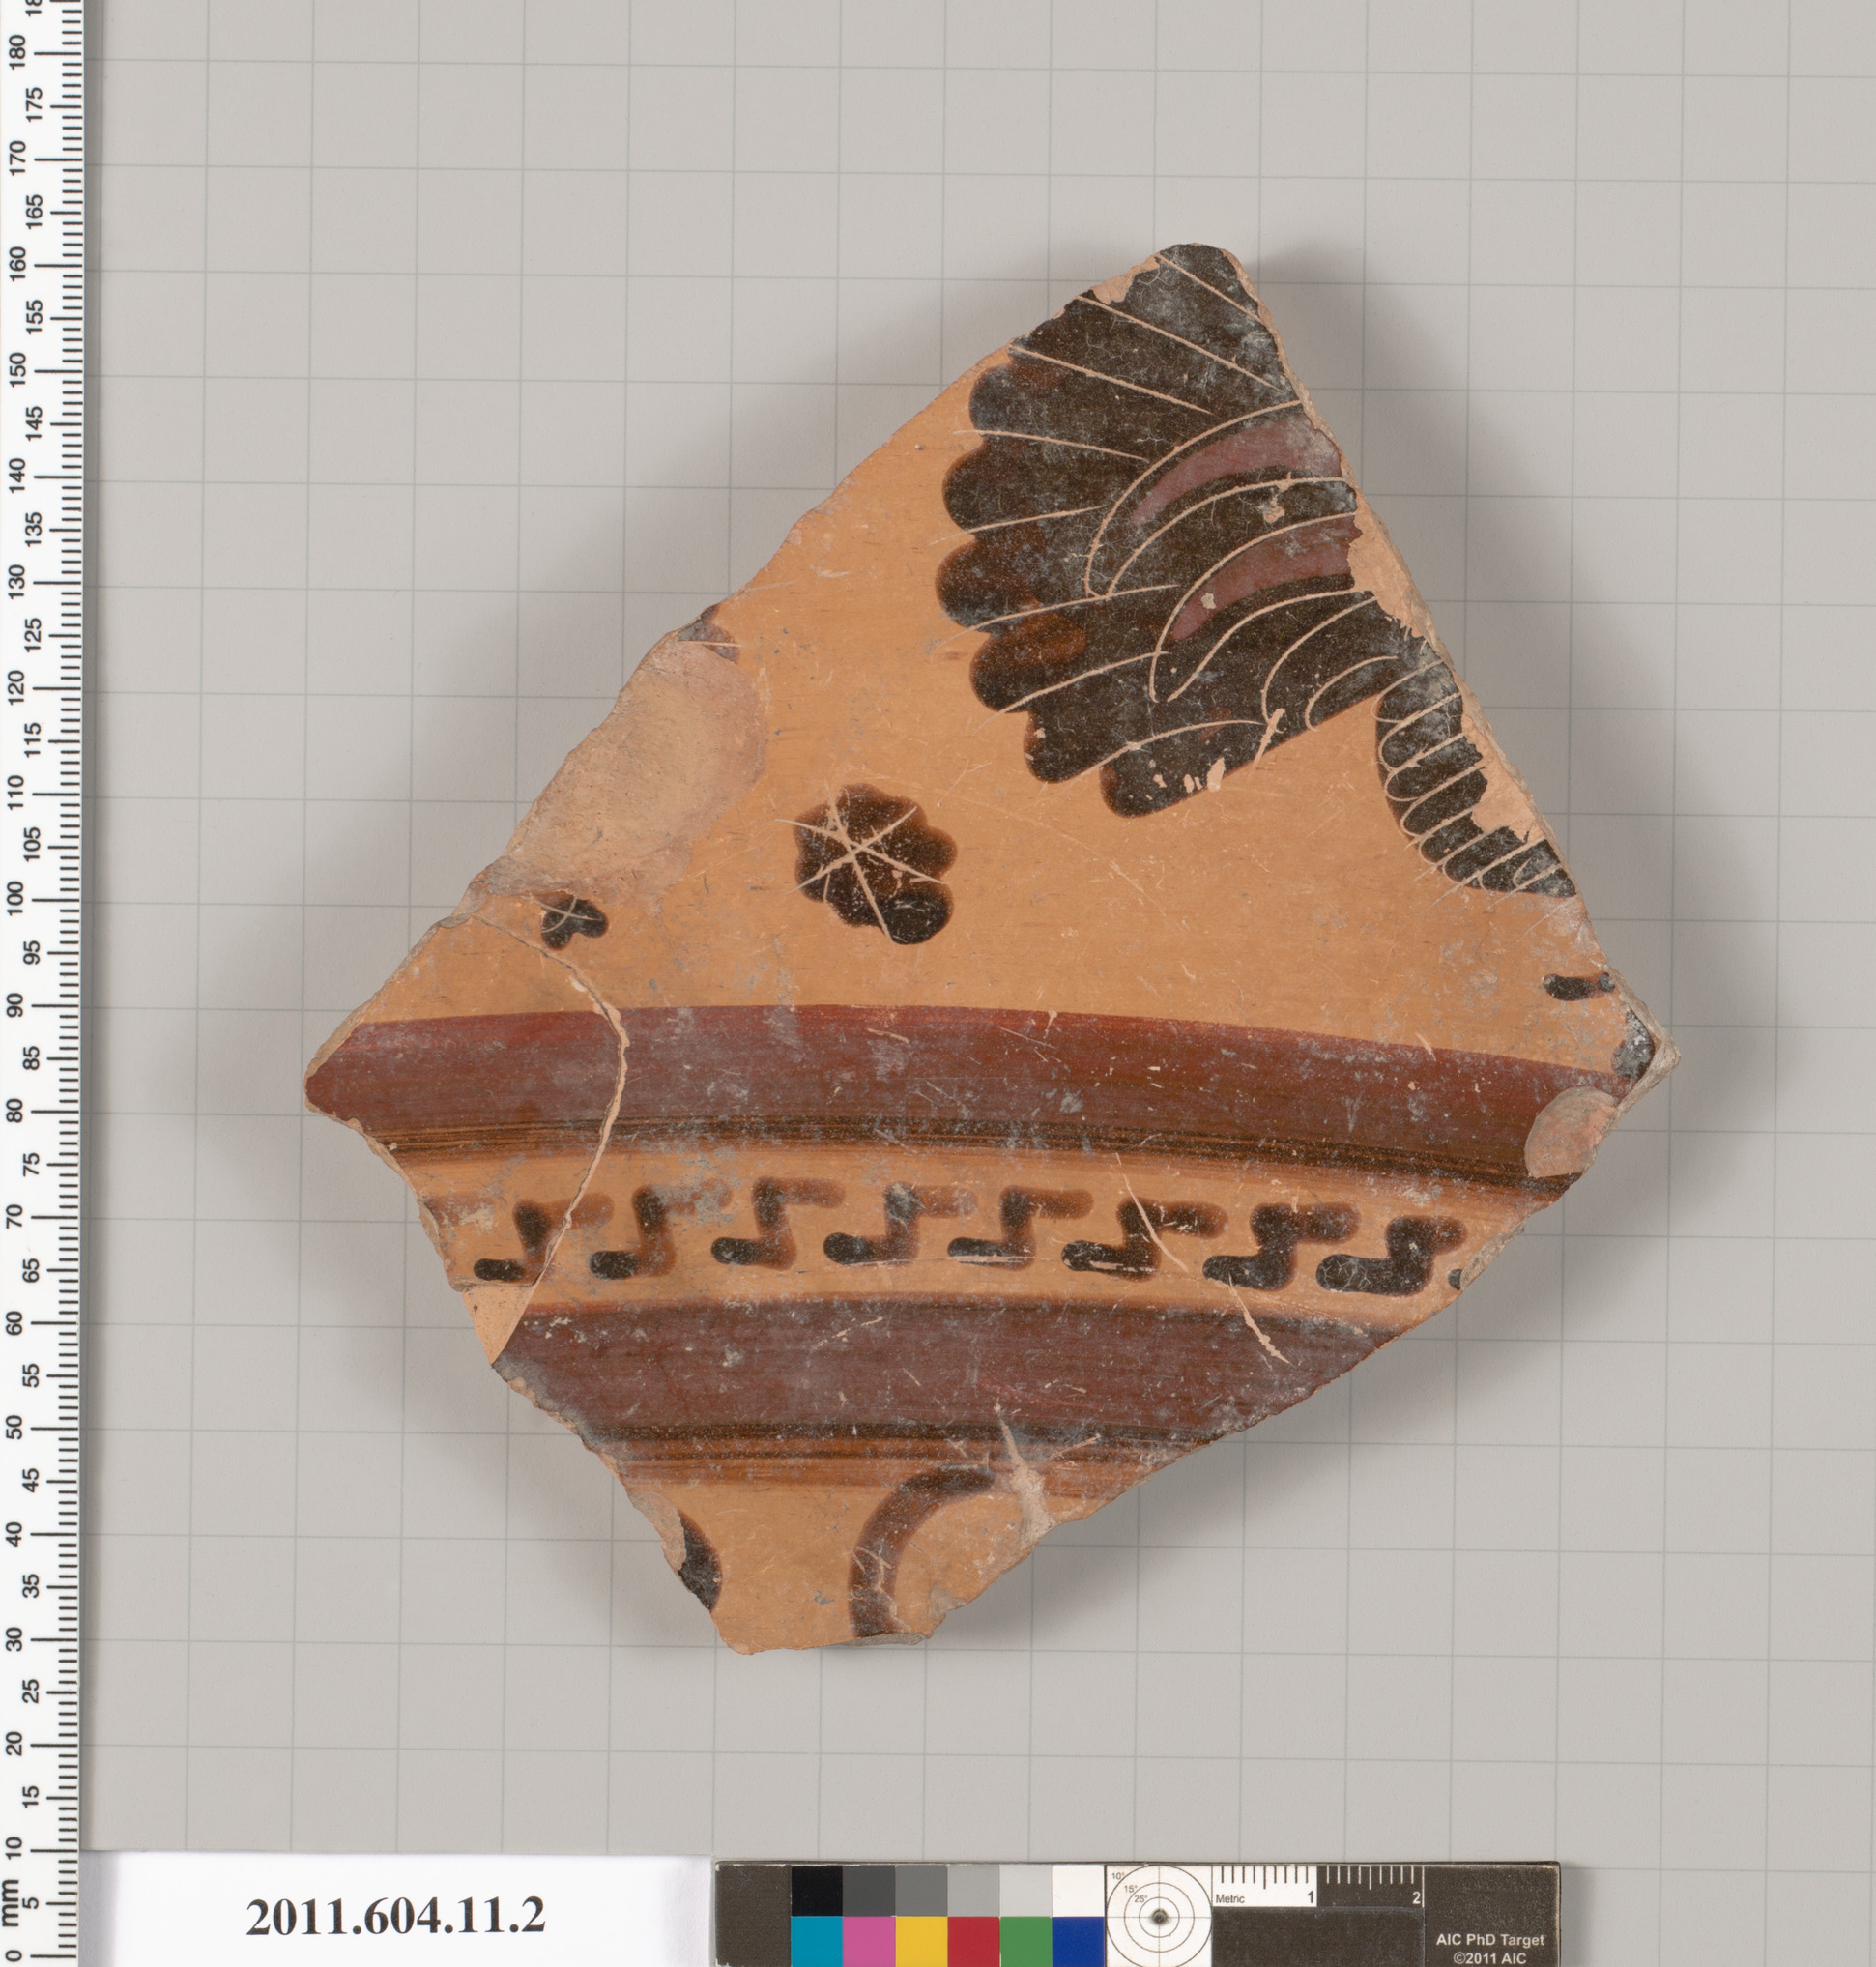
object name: undetermined open shape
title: Terracotta fragment of an undetermined open shape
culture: greek, chalcidian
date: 567-535 BCE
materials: terracotta